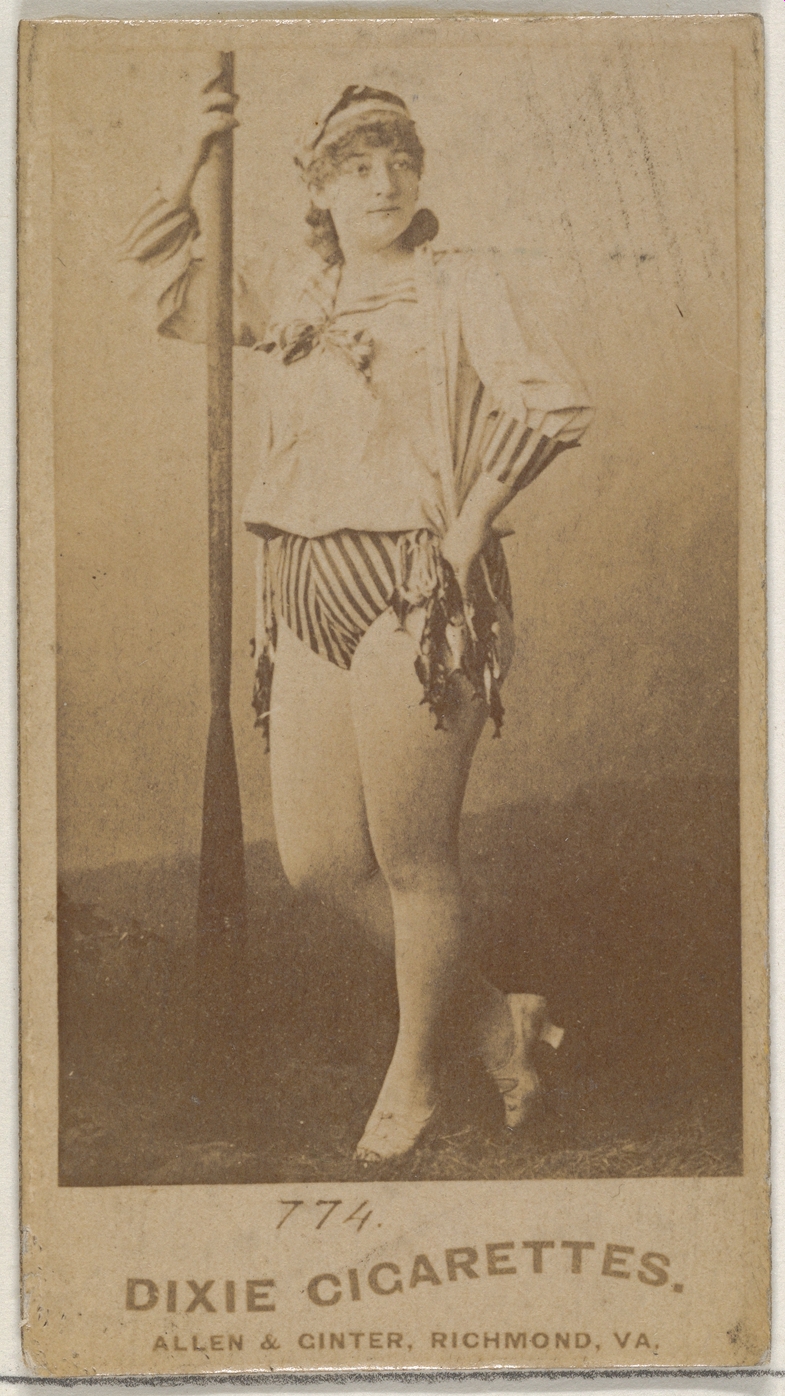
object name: photograph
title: Card 774, from the Actors and Actresses series (N45, Type 7) for Dixie Cigarettes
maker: allen & ginter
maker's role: publisher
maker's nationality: american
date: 1888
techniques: albumen silver print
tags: portraits,women,actresses